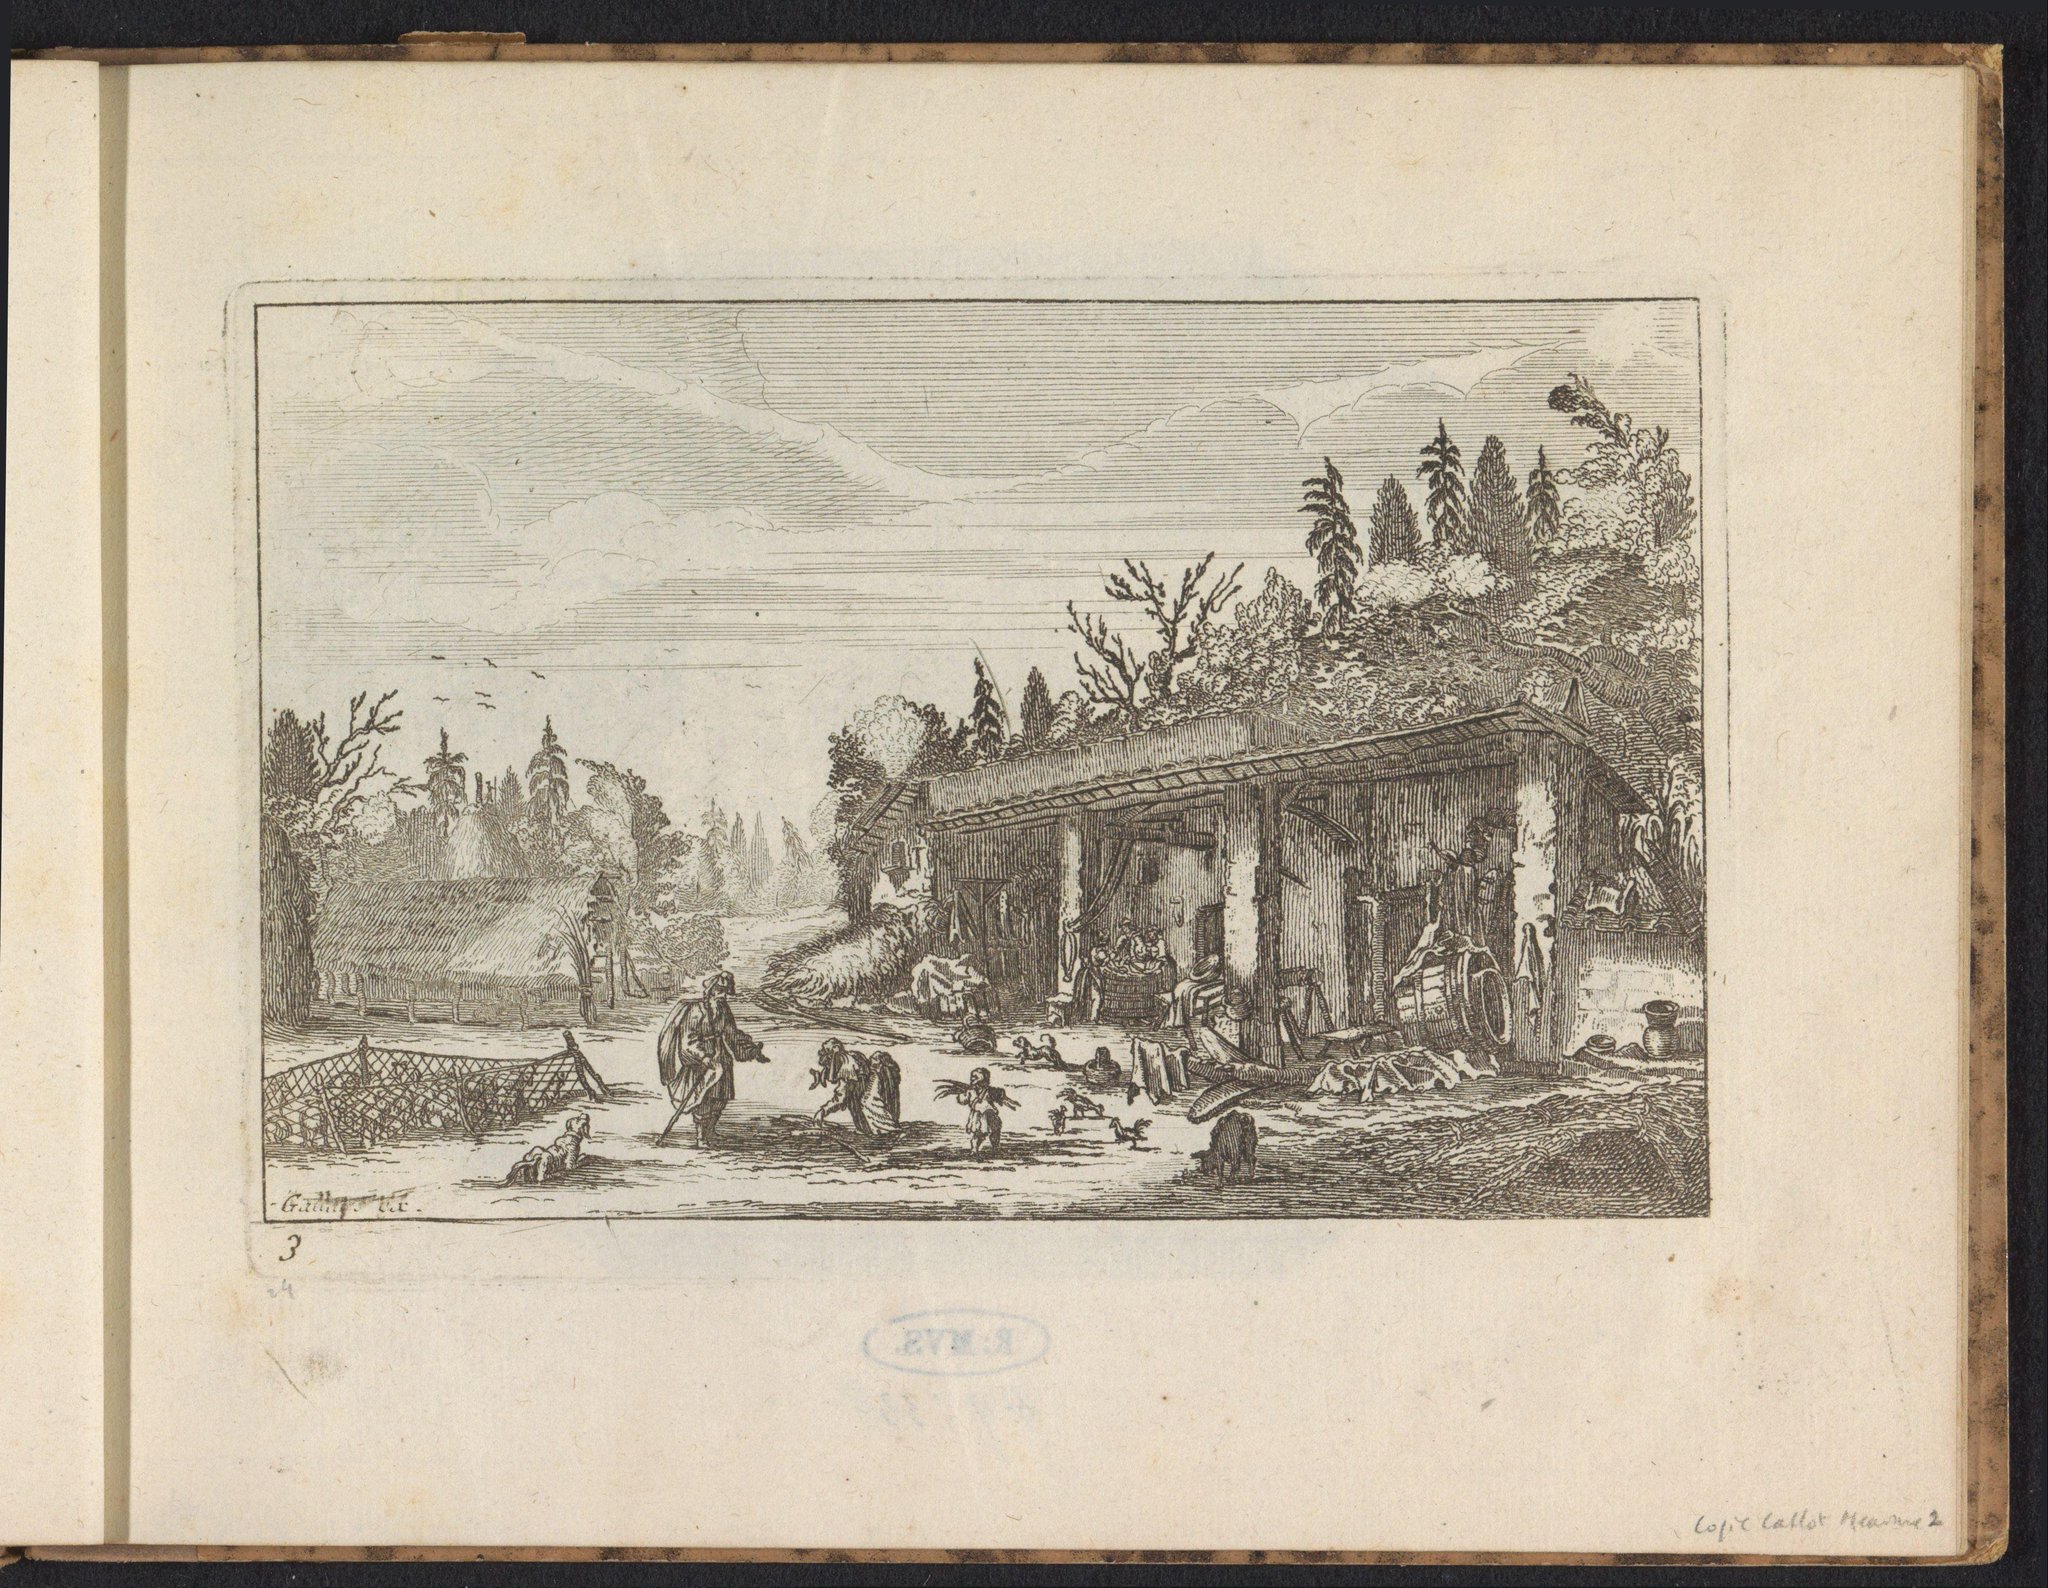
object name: album leaf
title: Elias en de weduwe van Sarepta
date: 1619-1699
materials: paper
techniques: etching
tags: animals, farmers, when the brook dries up, elijah crosses over to the city of zarephath; at the gate he meets a woman and her little son gathering wood (the woman's sticks may form a cross)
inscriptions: collector's mark: Lugt 2228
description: Gezicht op een boerenerf. Links staat een groep geiten binnen een afrastering. Op de voorgrond praat een oude man (Elias) met een vrouw (de weduwe van Sarepta) terwijl zij met haar zoon hout sprokkelt. Drie wasvrouwen kijken toe.